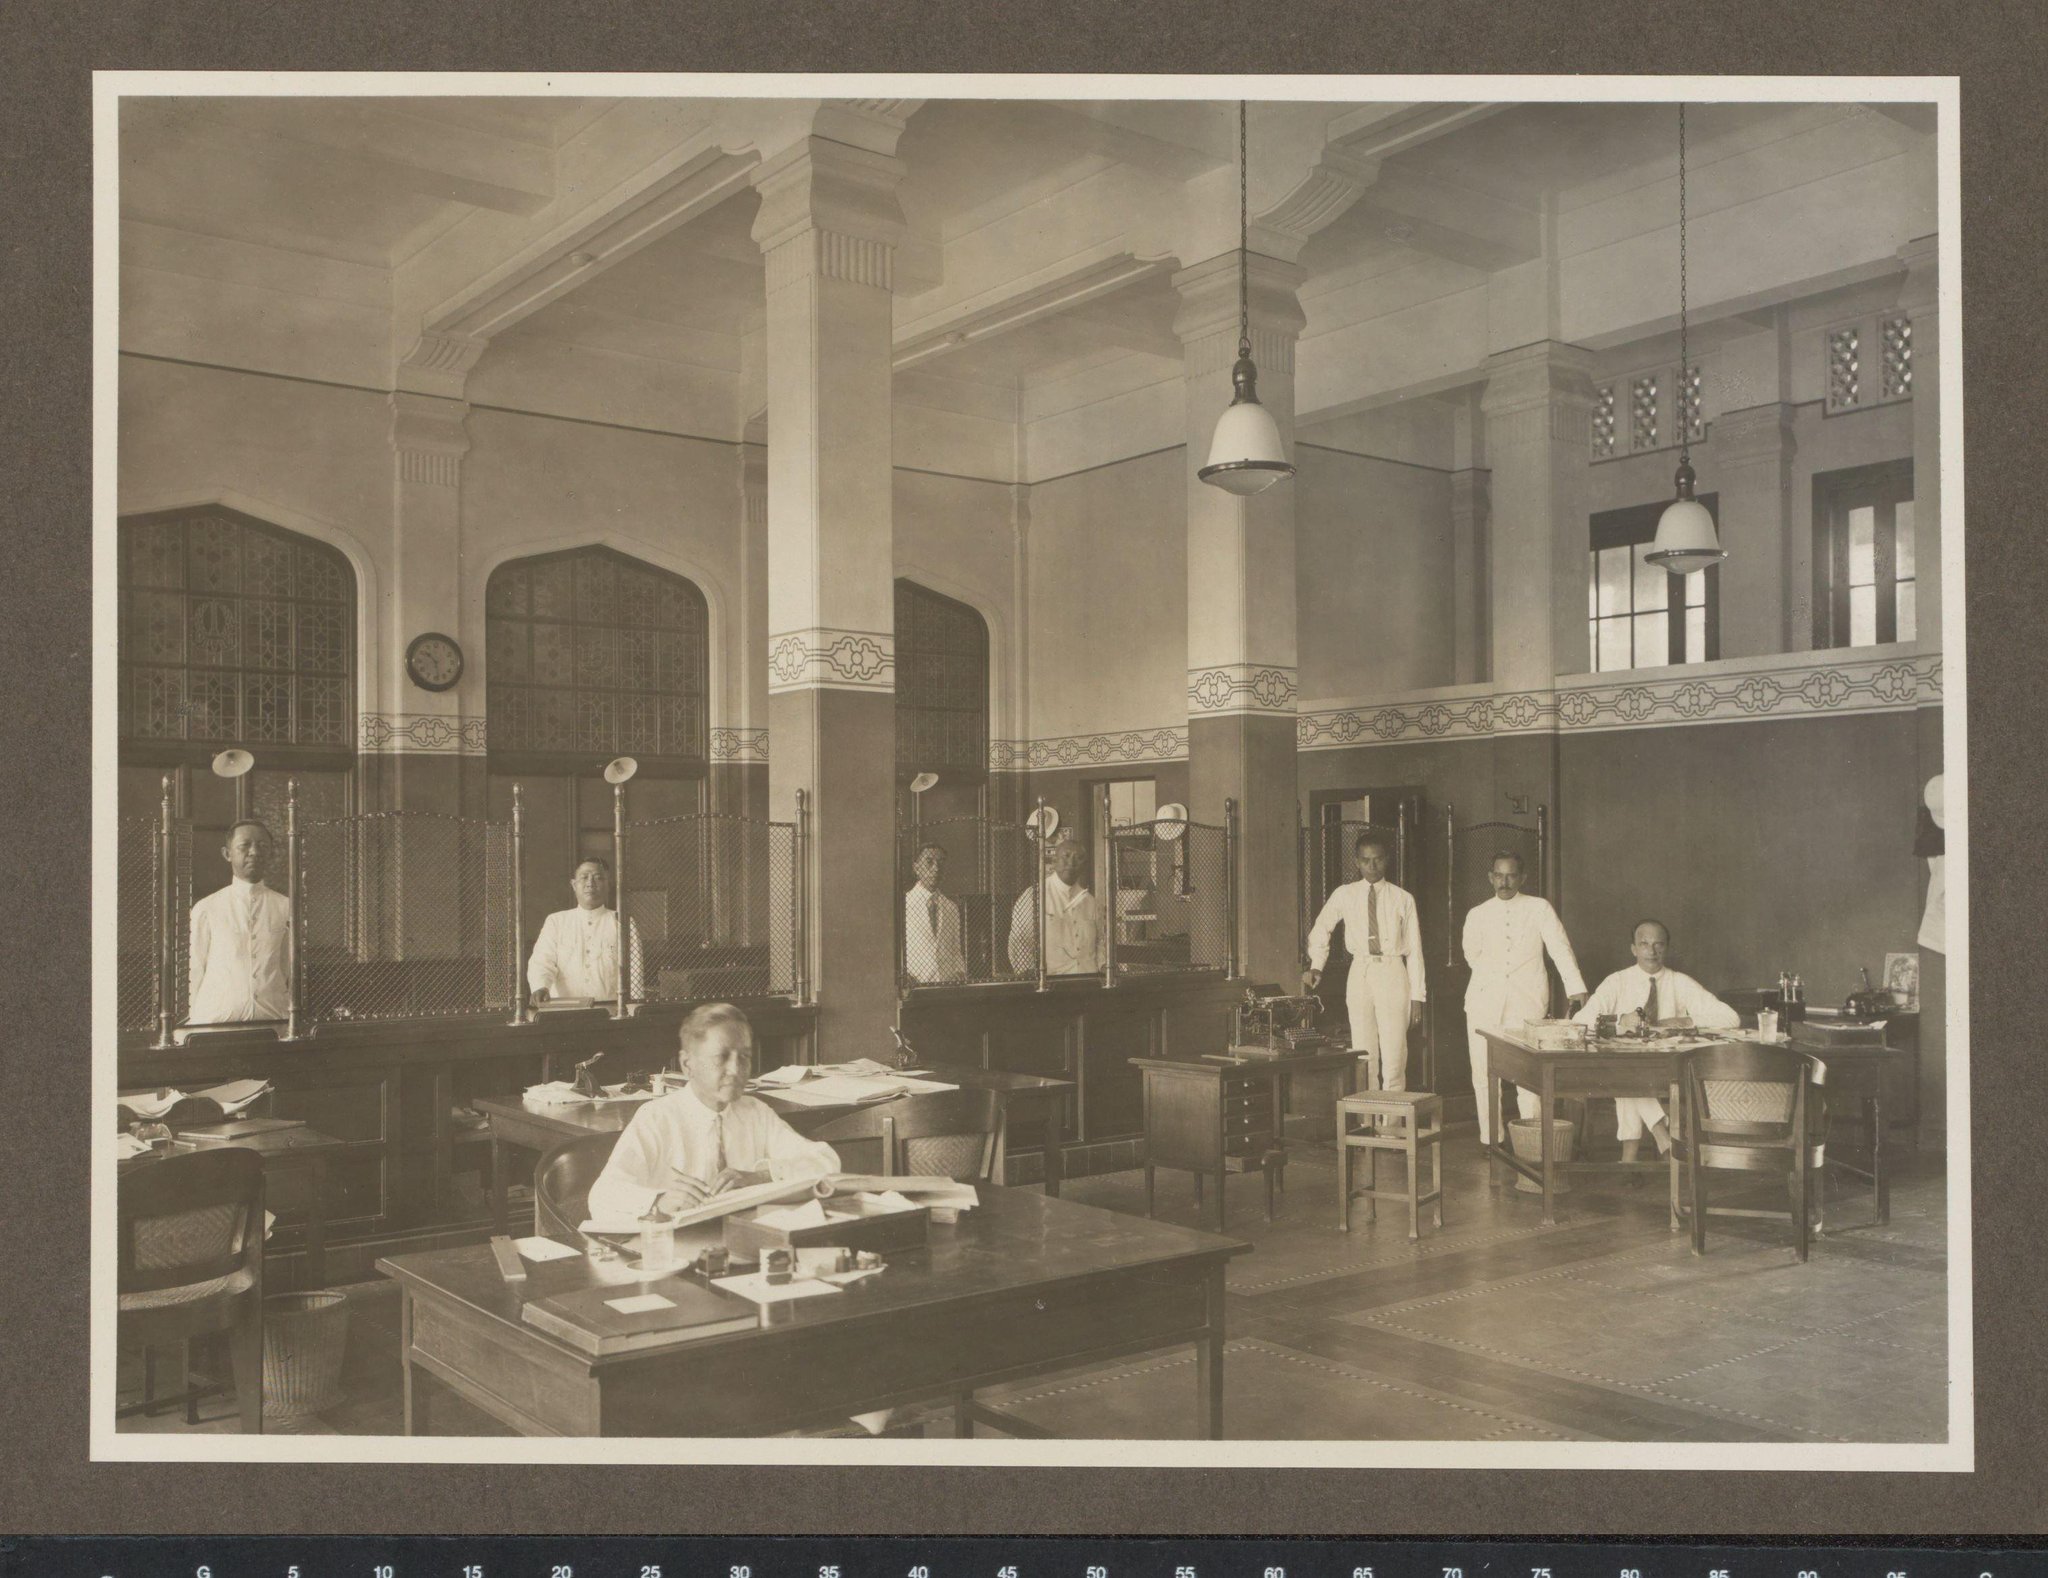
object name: photograph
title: Boekhoud afdeeling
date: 1904-1931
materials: photographic support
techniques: gelatin silver print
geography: surabaya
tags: colonial system, trade-company, administration ~ trade and finance, surabaya, java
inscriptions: inscription: ‘Boekhoud afdeeling’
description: De afdelingen boekhouding, met de Europese en Javaanse werknemers bij hun bureaus en achter loketten. Foto in het het fotoalbum aangeboden aan A. van der Eyk namens de chefs en het personeel van de Handelsvereniging Amsterdam (HVA) te Soerabaja bij zijn vertrek van Java in april 1931.